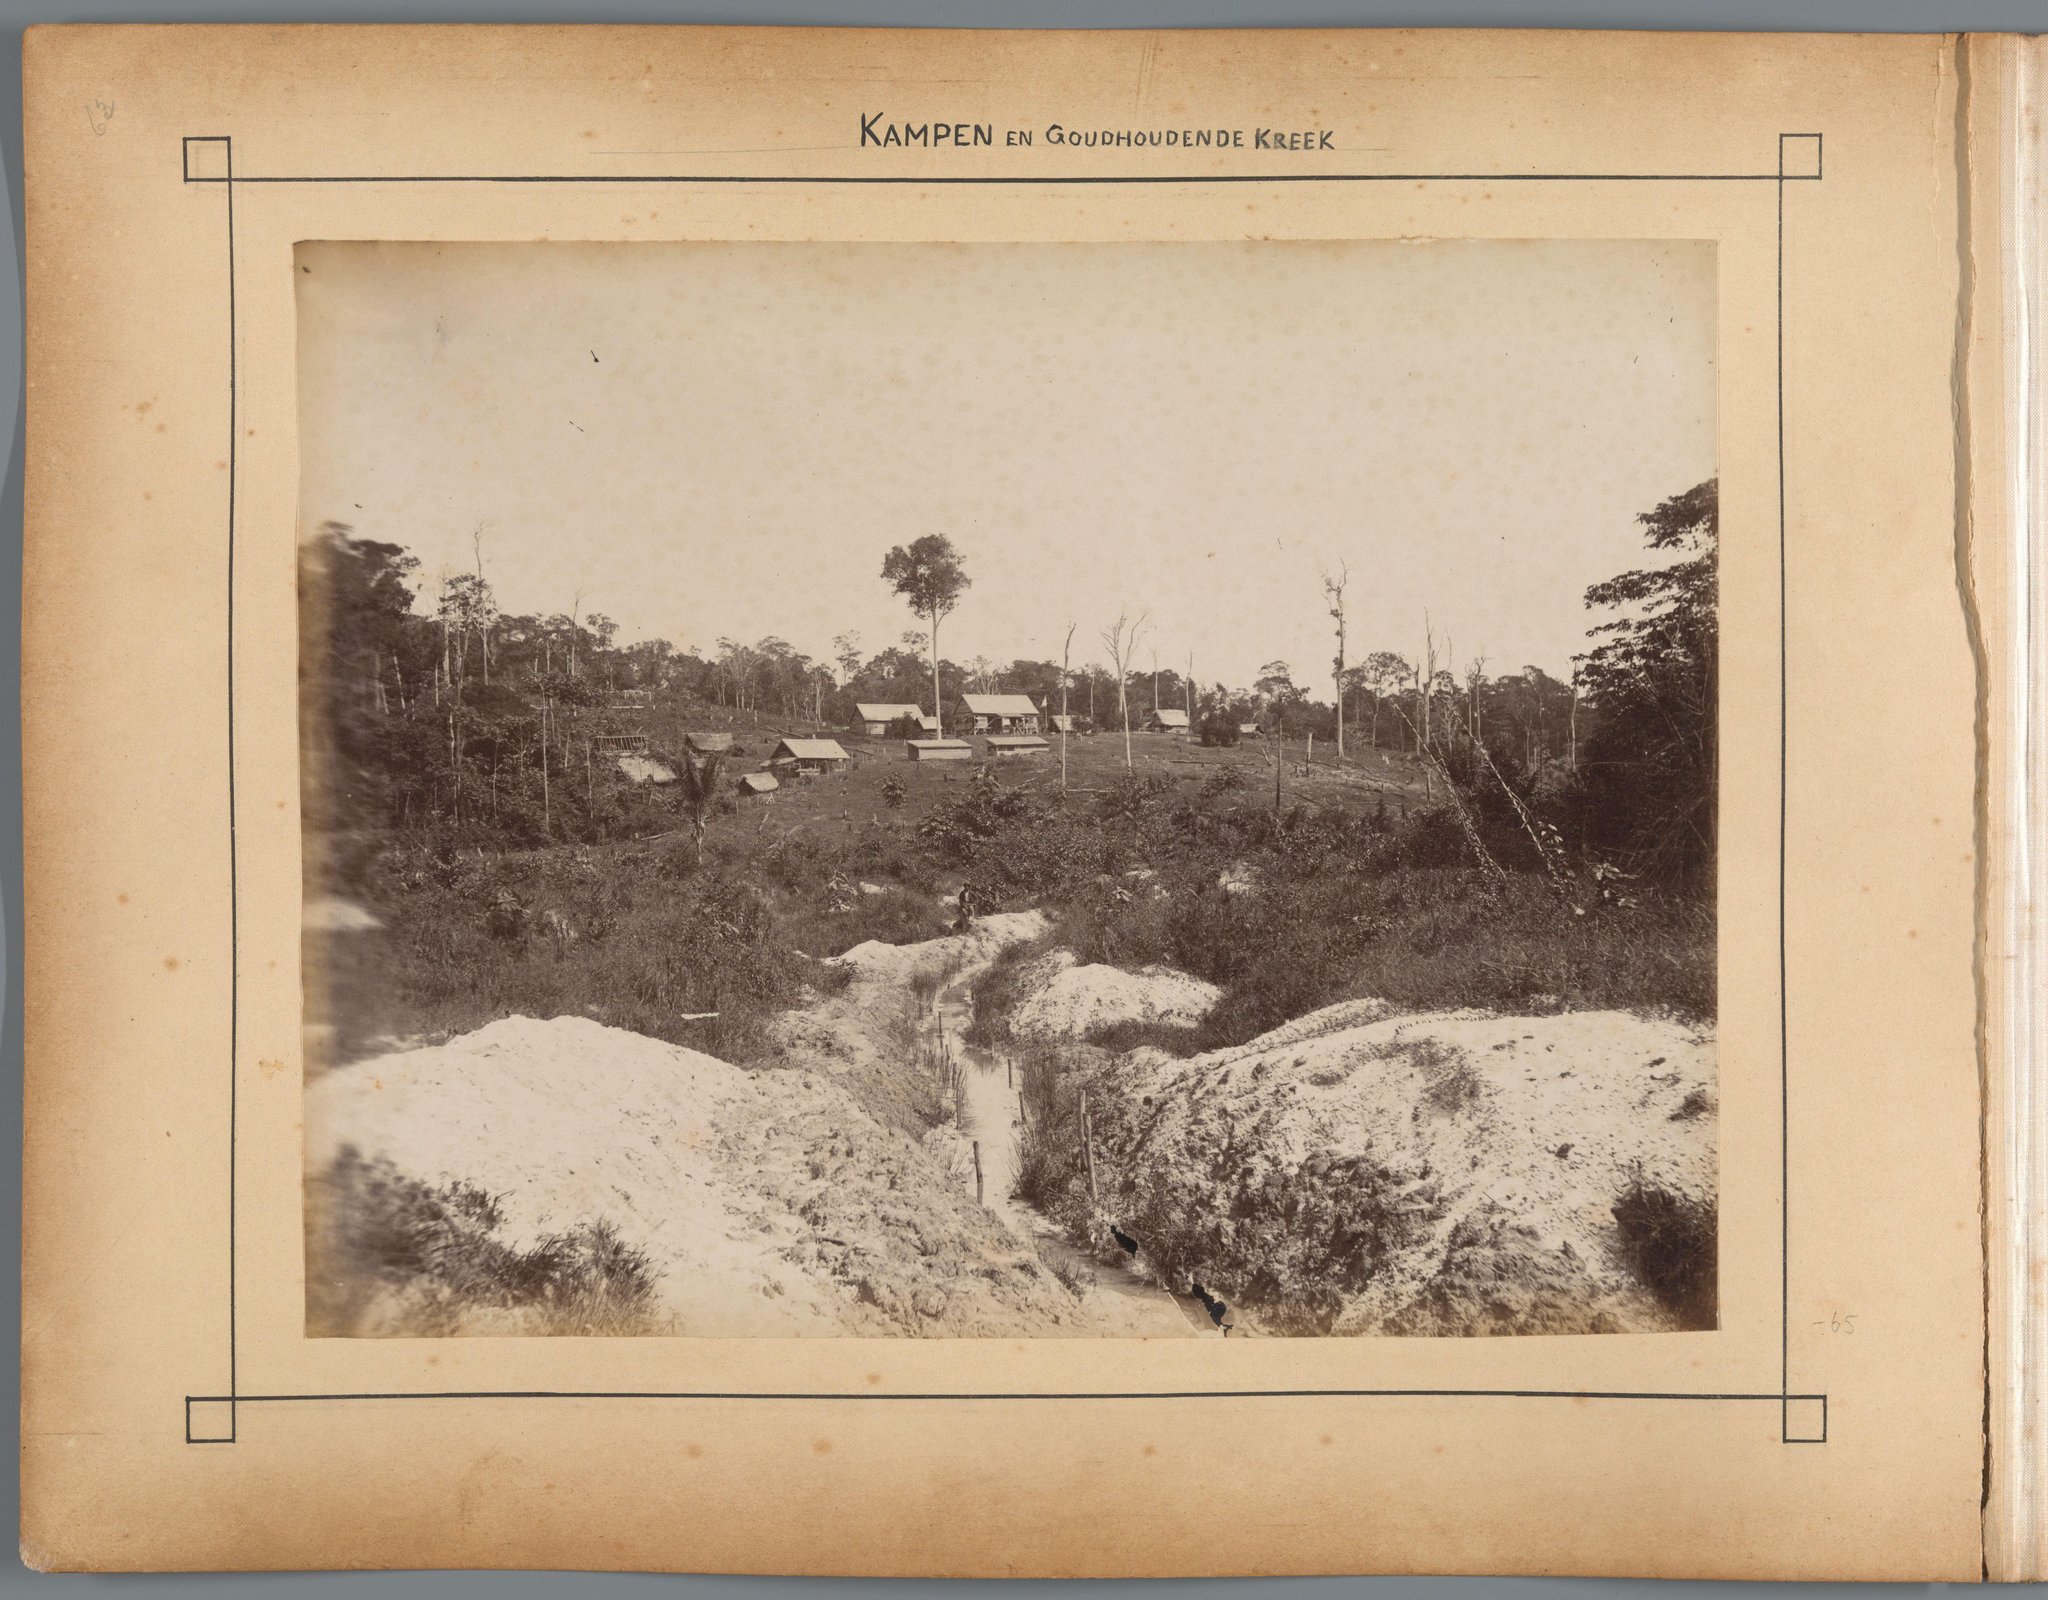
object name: photograph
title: Kampen en goudhoudende kreek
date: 1898-1902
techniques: albumen print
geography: suriname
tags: suriname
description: Kampen van arbeiders in de goudwinning bij een kreek.